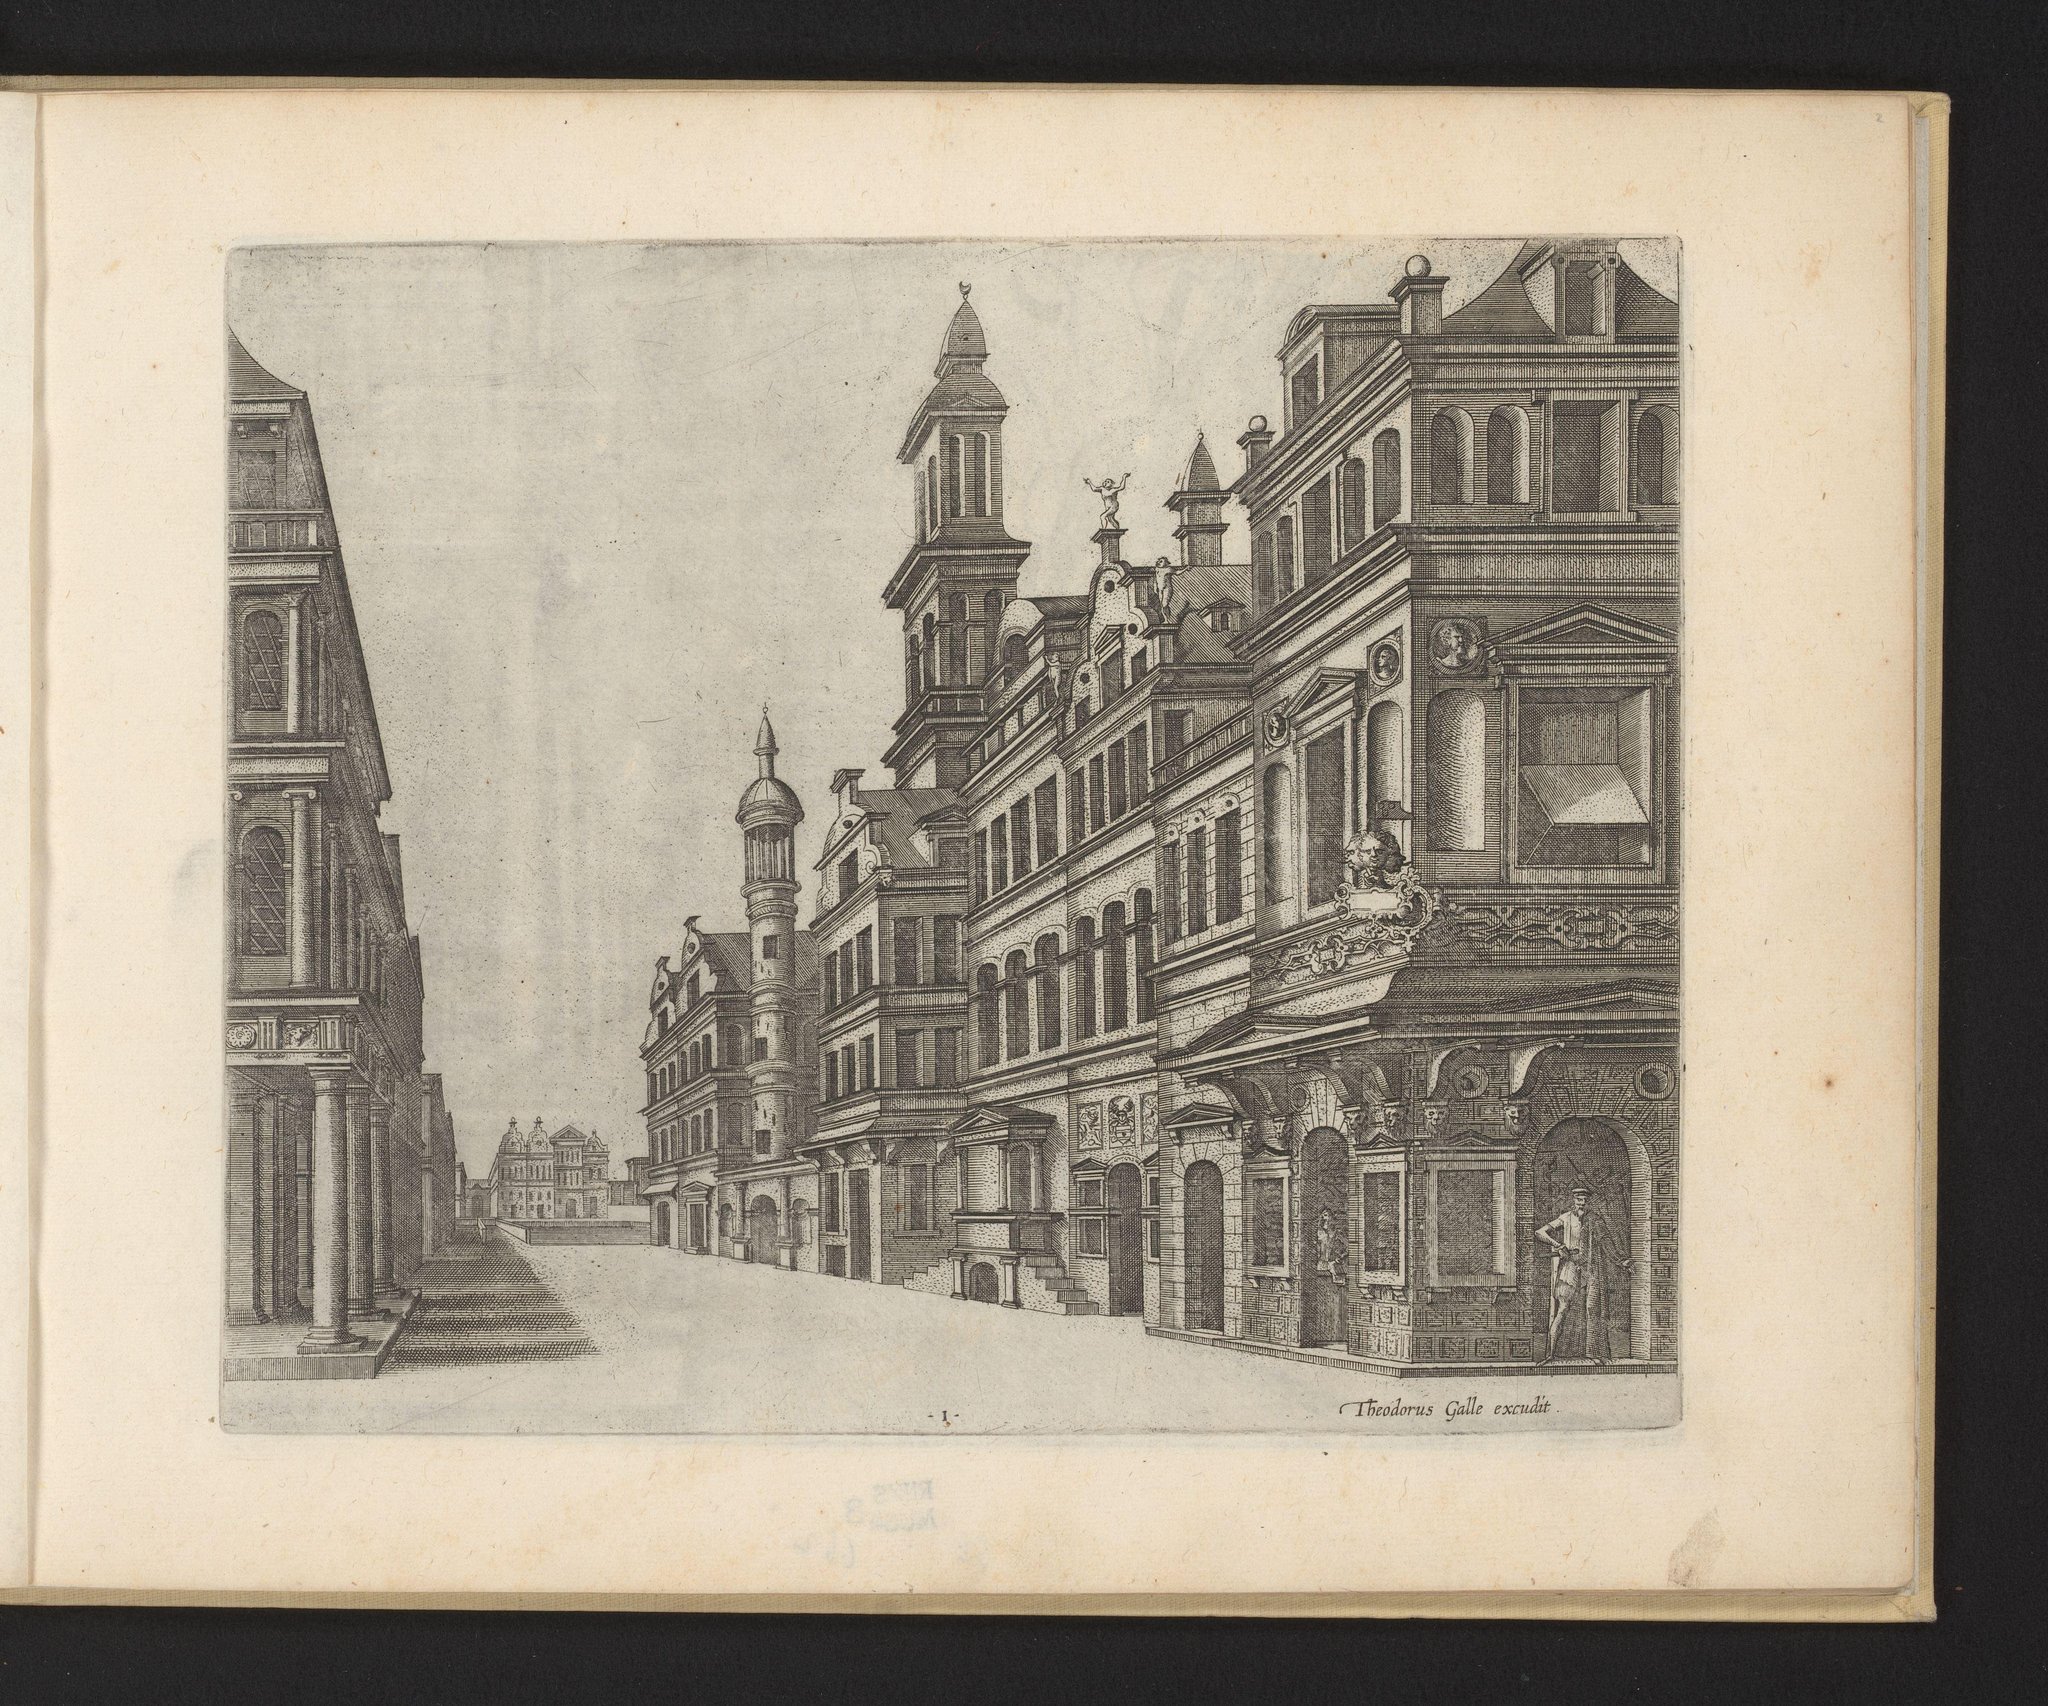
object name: album leaf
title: Gezicht in een straat met op de hoek de prentwinkel van Hieronymus Cock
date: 1601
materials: paper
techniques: engraving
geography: antwerp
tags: leiden, weduwe hieronymus cock (volcxken diericx), antwerp, print maker, publisher, hieronymus cock, city-view, and landscape with man-made constructions, publishing, publisher, street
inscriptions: collector's mark: ‘RIJKS / MUSM’, collector's mark: ‘B’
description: Gezicht in een straat met op de hoek de prentwinkel en uitgeverij van Hieronymus Cock. In twee deuropeningen een vrouw en een man, wellicht het uitgeversechtpaar Volcxken Diericx en Hieronymus Cock. De prent maakt deel uit van een album.